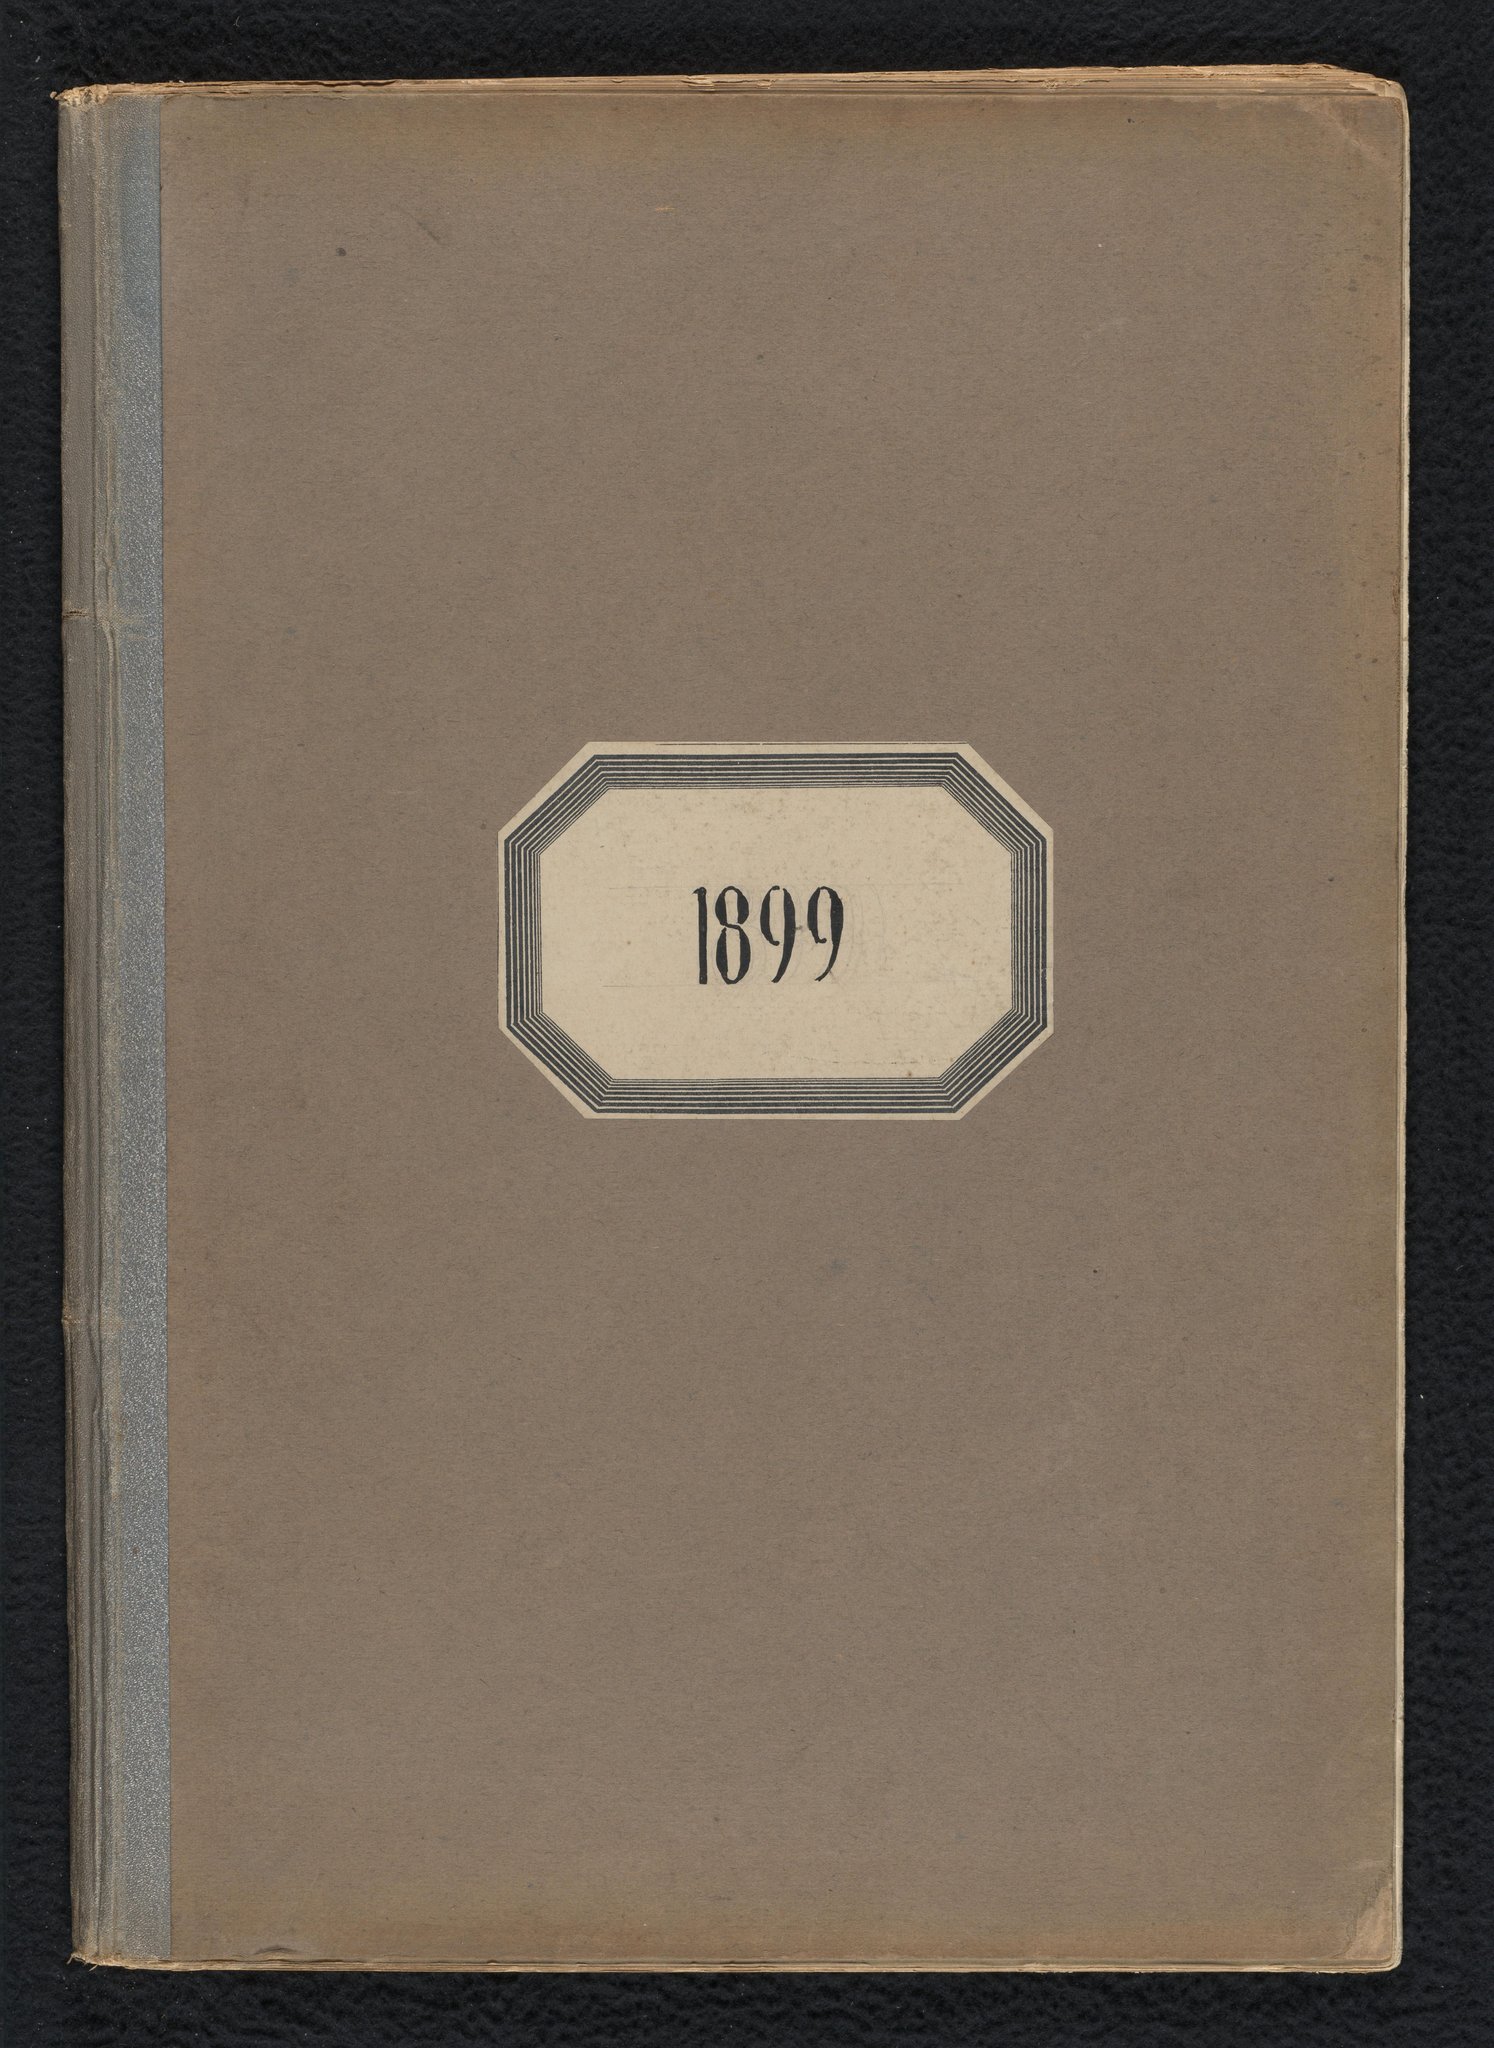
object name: cartoon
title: Spotprenten uit 'De Amsterdammer' van het jaar 1899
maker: johan braakensiek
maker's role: draughtsman, print maker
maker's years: 1858-1940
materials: paper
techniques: lithograph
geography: netherlands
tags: political caricatures and satires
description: Bundel van 55 spotprenten van Braakensiek gepubliceerd als bijvoegsel bij 'De Amsterdammer' in het jaar 1899. Bundel geplakt in slappe omslag van grijsgroen karton met handgeschreven etiket '1899'.